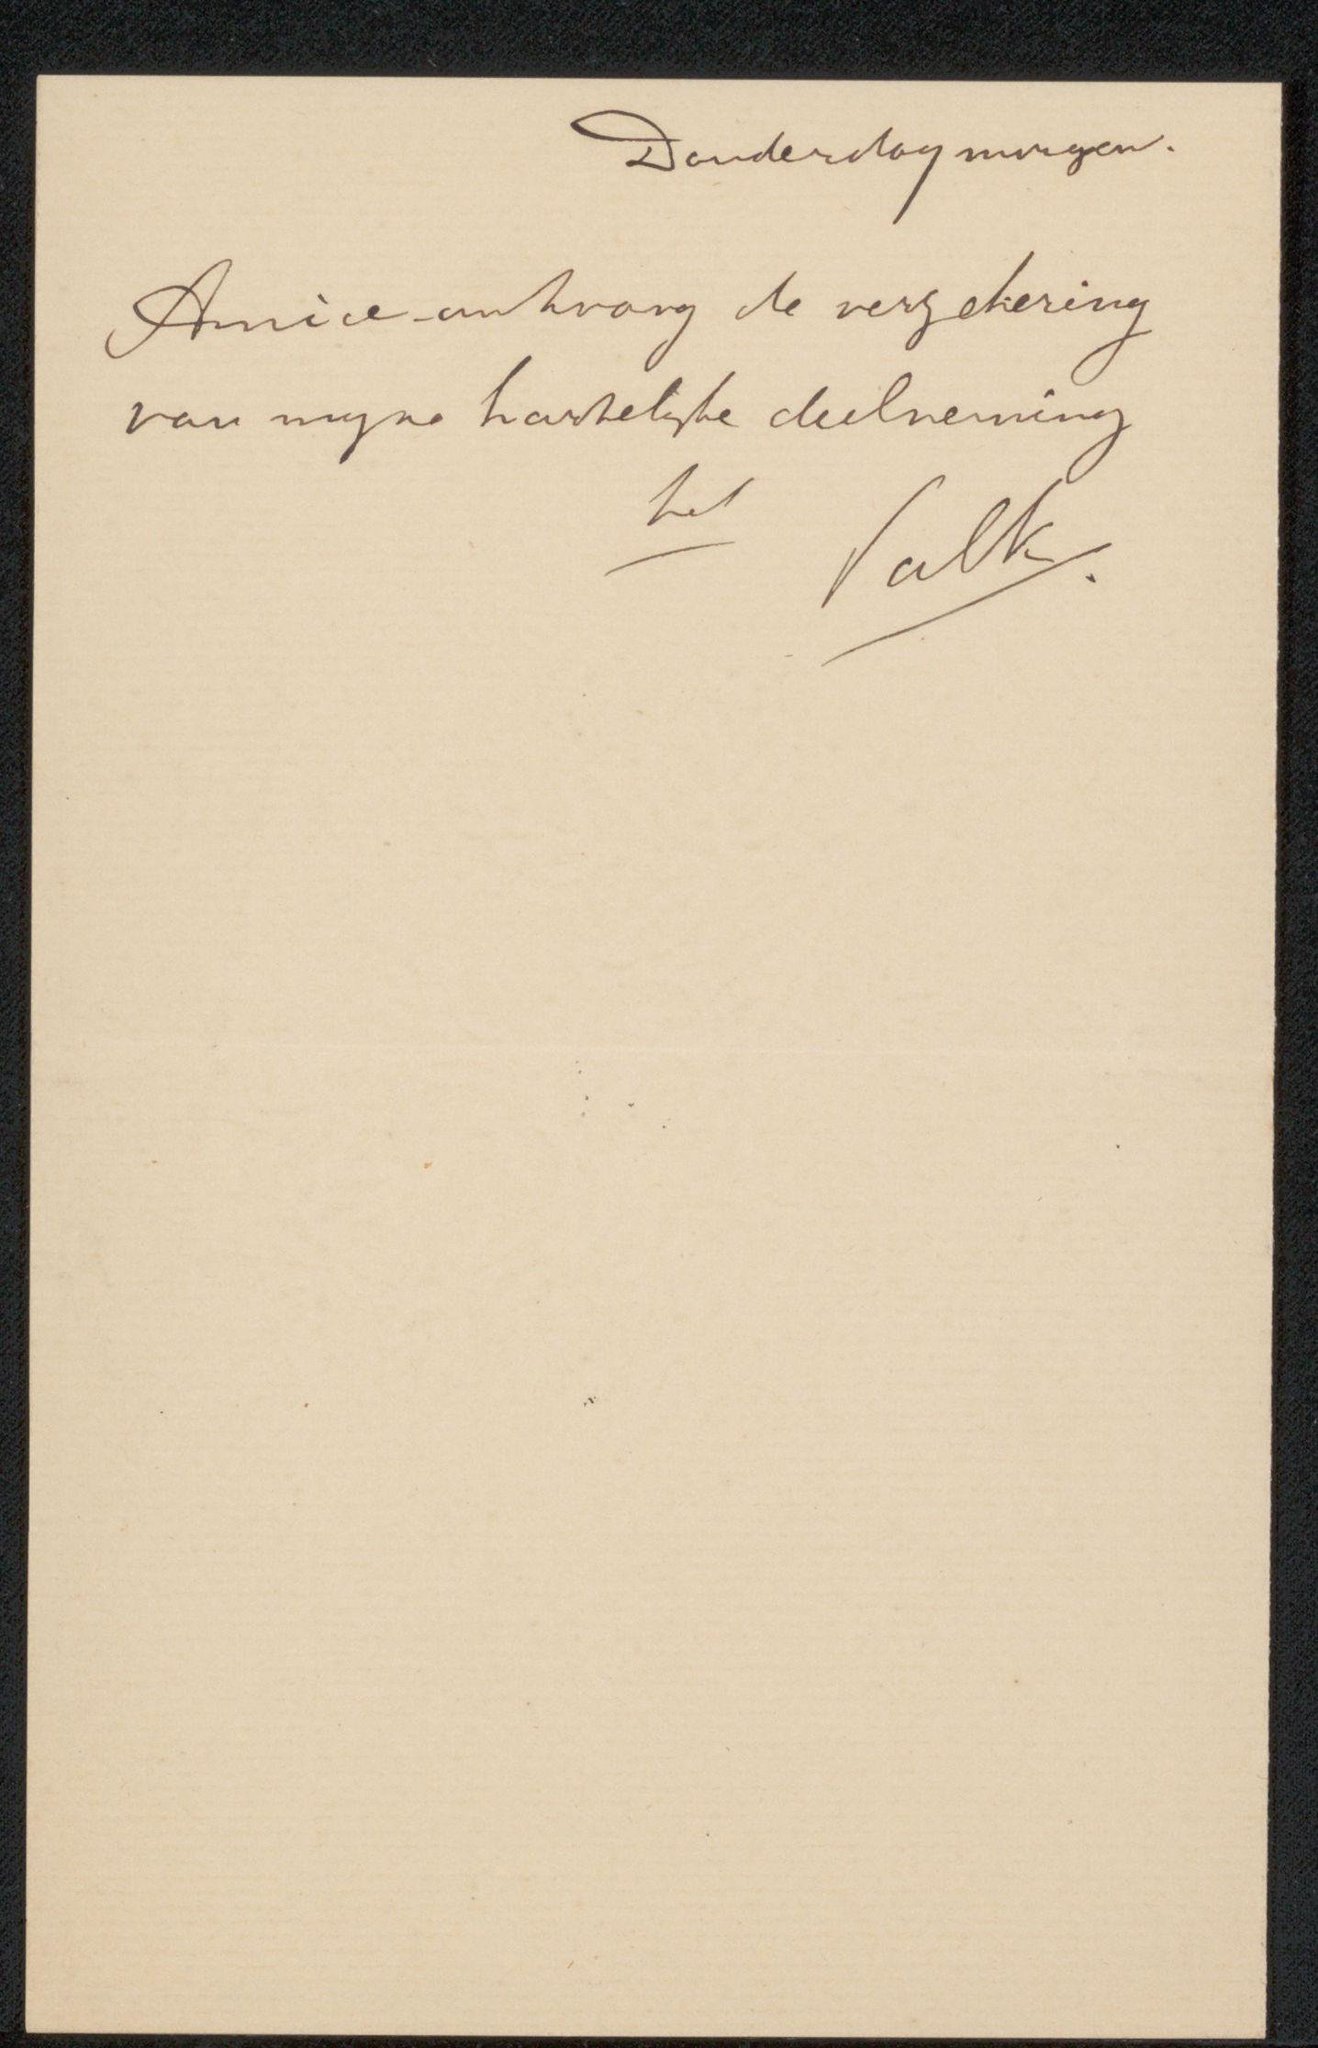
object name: letter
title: Brief aan Philip Zilcken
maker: maurits van der valk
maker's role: draughtsman, print maker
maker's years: 1857-1935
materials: ink, paper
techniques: pen, writing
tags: helène lambertine hauzeur, the hague, painter, draughtsman, philip zilcken, passions, emotions, affections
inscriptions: watermark